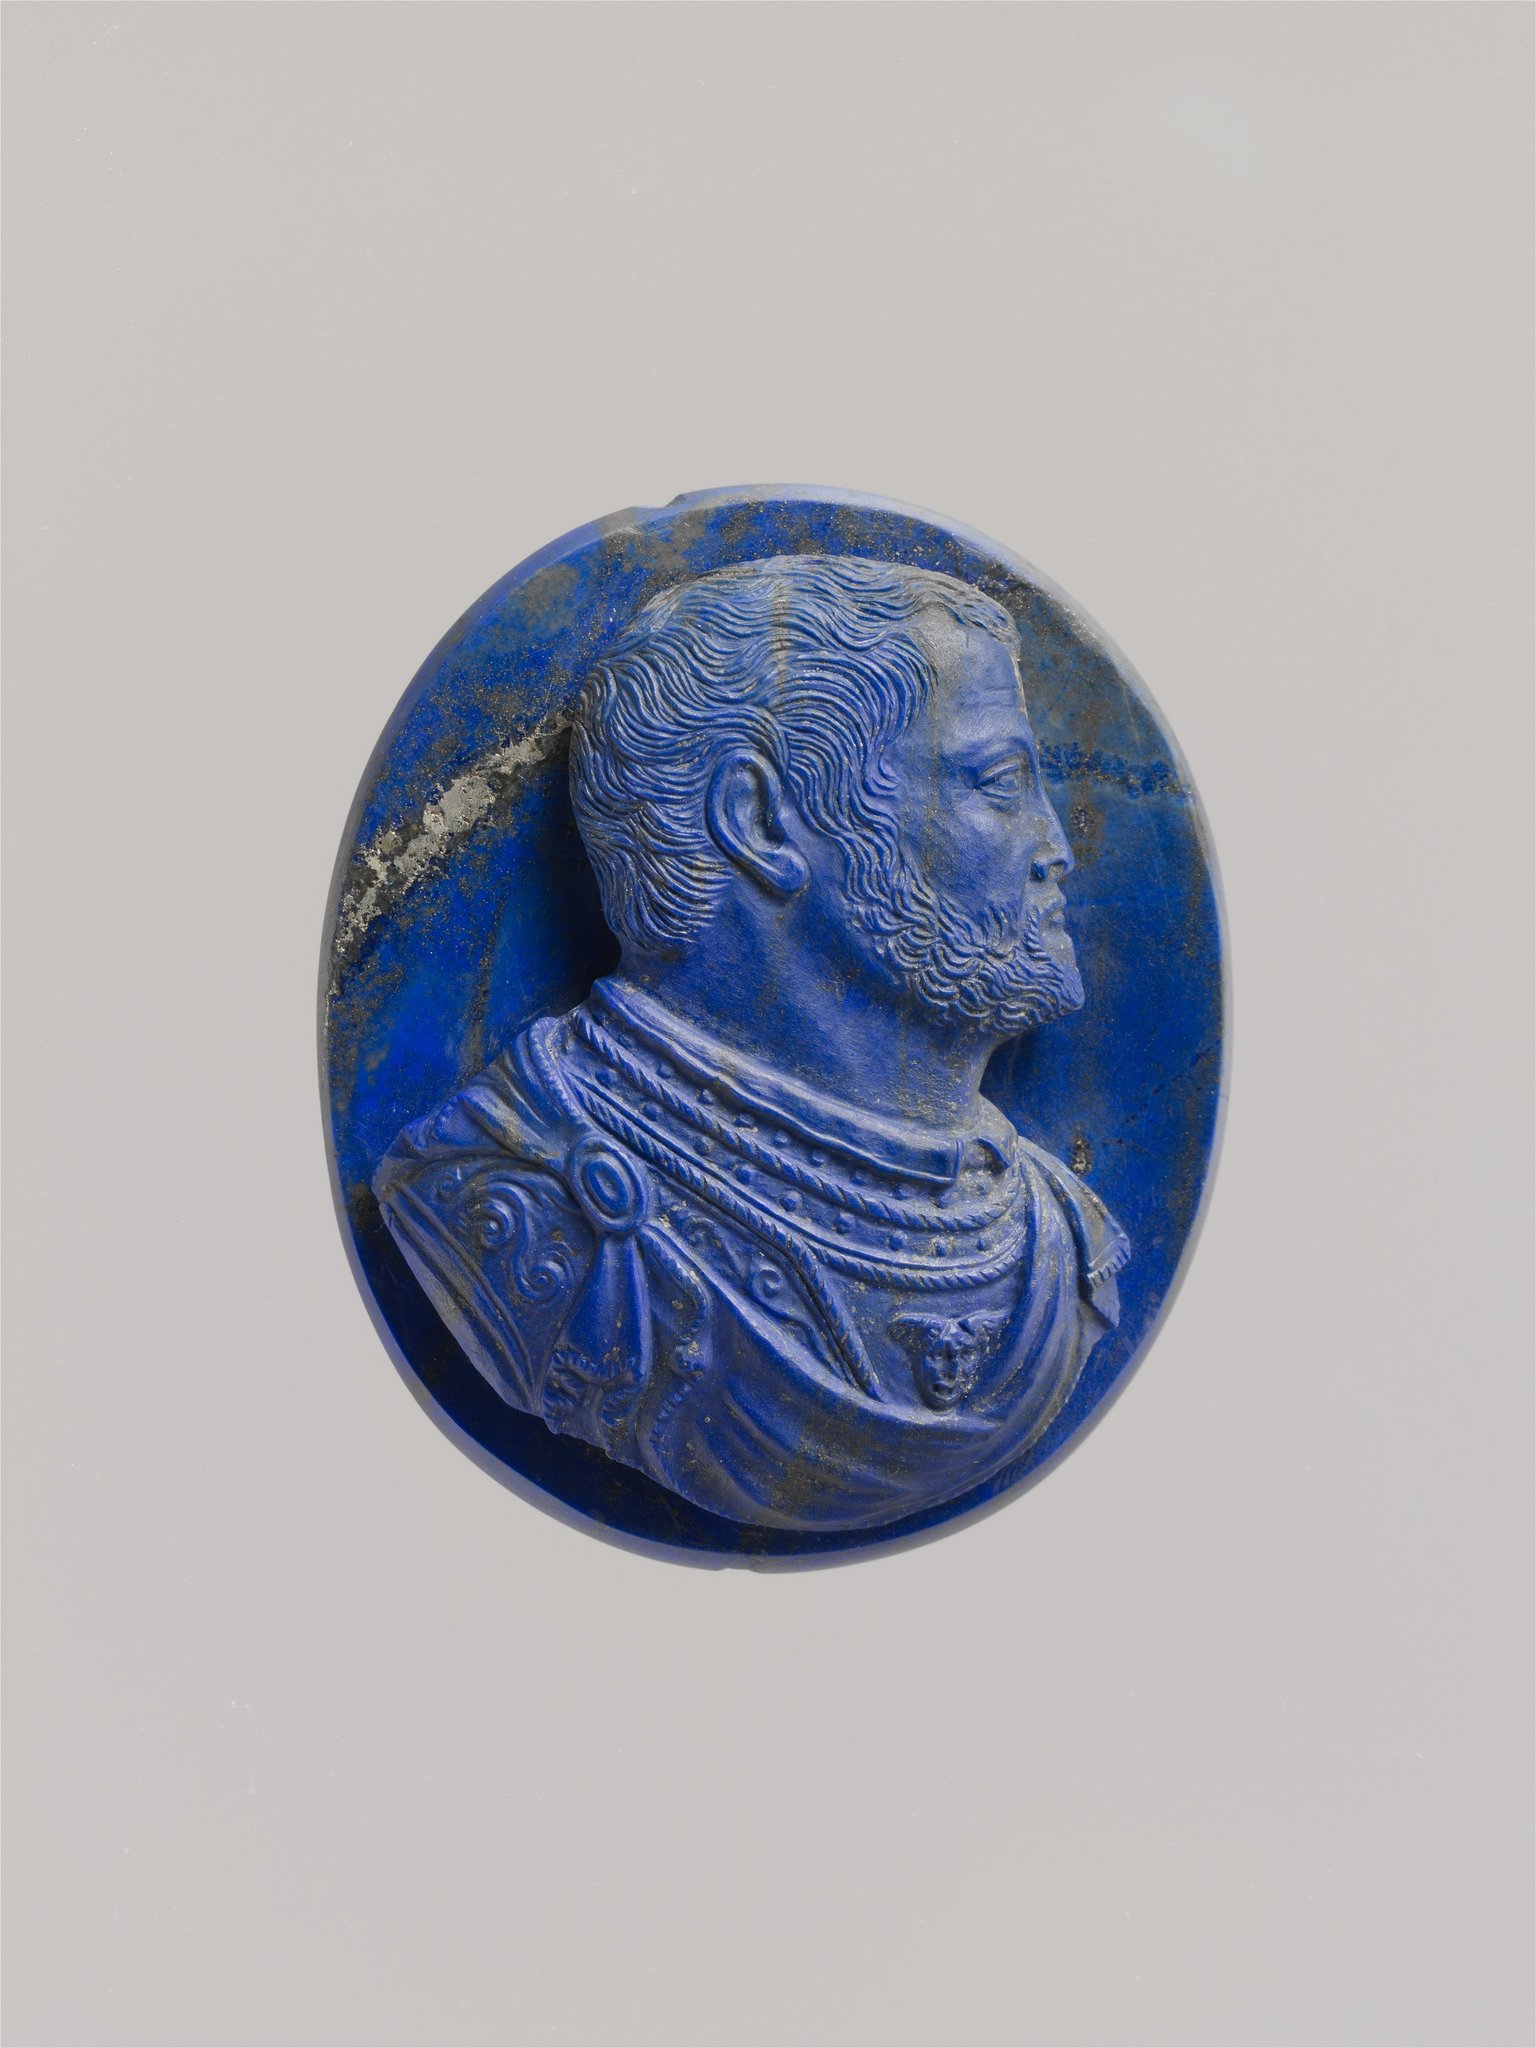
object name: cameo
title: Cosimo de' Medici (1519–1574), Duke of Florence and Grand Duke of Tuscany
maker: grand-ducal workshops, florence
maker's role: artist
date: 1567-1569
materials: lapis lazuli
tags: men,profiles